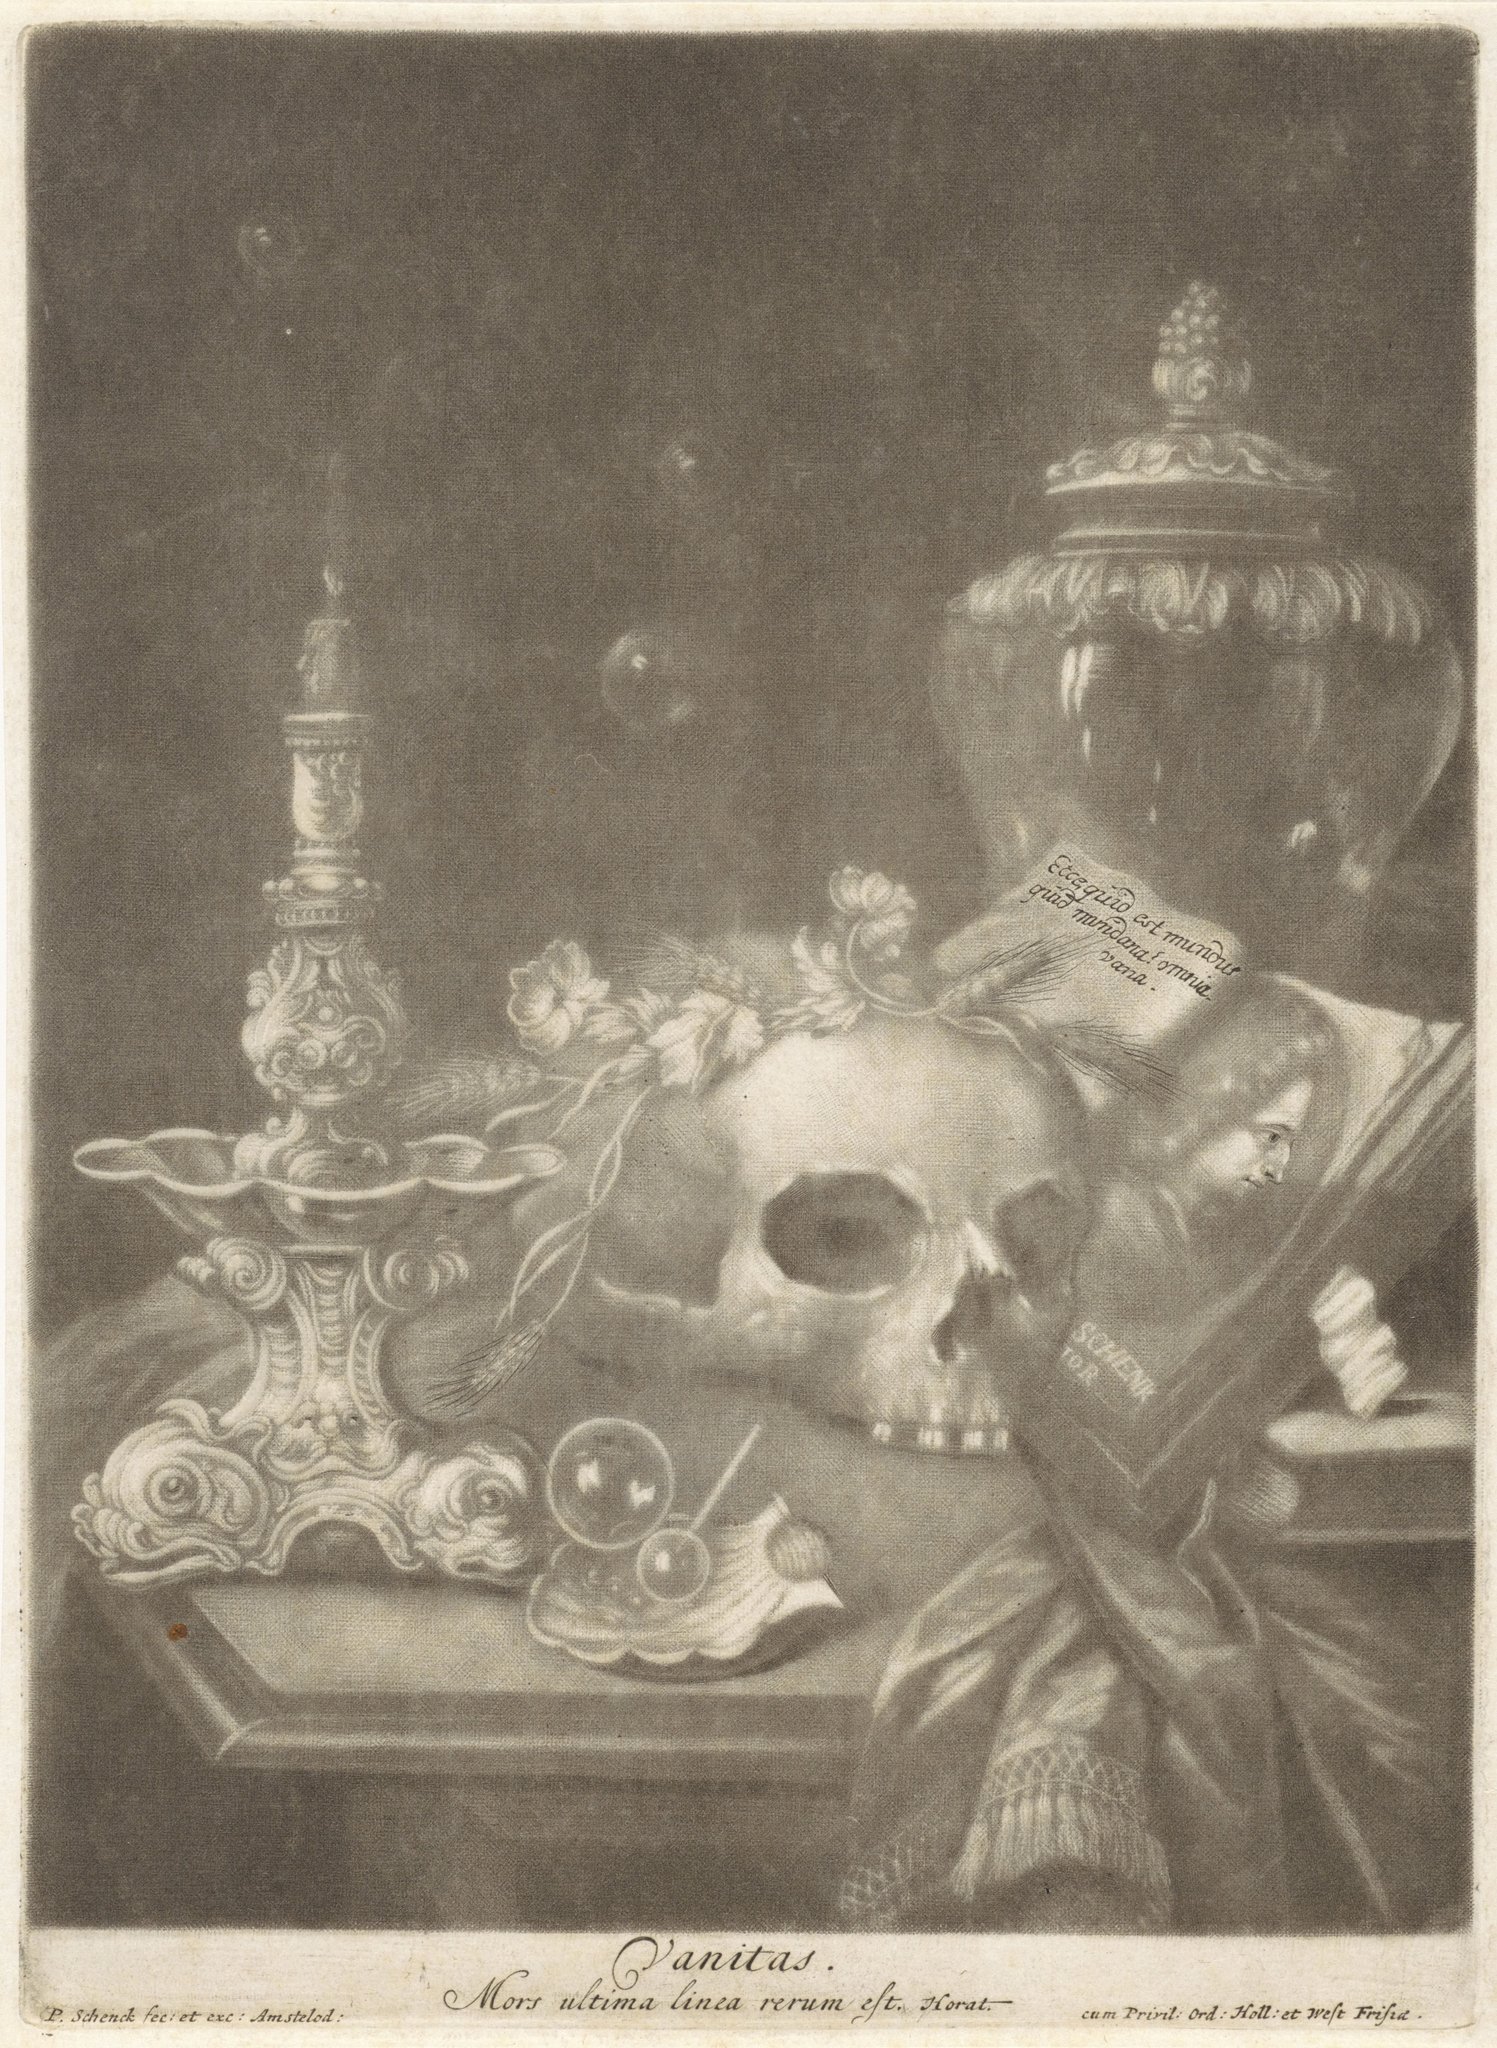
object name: print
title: Vanitas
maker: pieter schenk (i)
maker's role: print maker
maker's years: 1660-1711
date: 1670-1713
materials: paper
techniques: engraving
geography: amsterdam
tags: skull as symbol of 'vanitas', 'vanitas' still life, soap-bubble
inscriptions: collector's mark: Lugt 2228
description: Vanitasstilleven met een bloembekranste schedel, portretalbum, kostbare kandelaar met gedoofde kaars, een vat en zeepbellen. In de marge een citaat van Horatius 'Mors ultima lenea rerum est' ('De dood is de eindstreep').